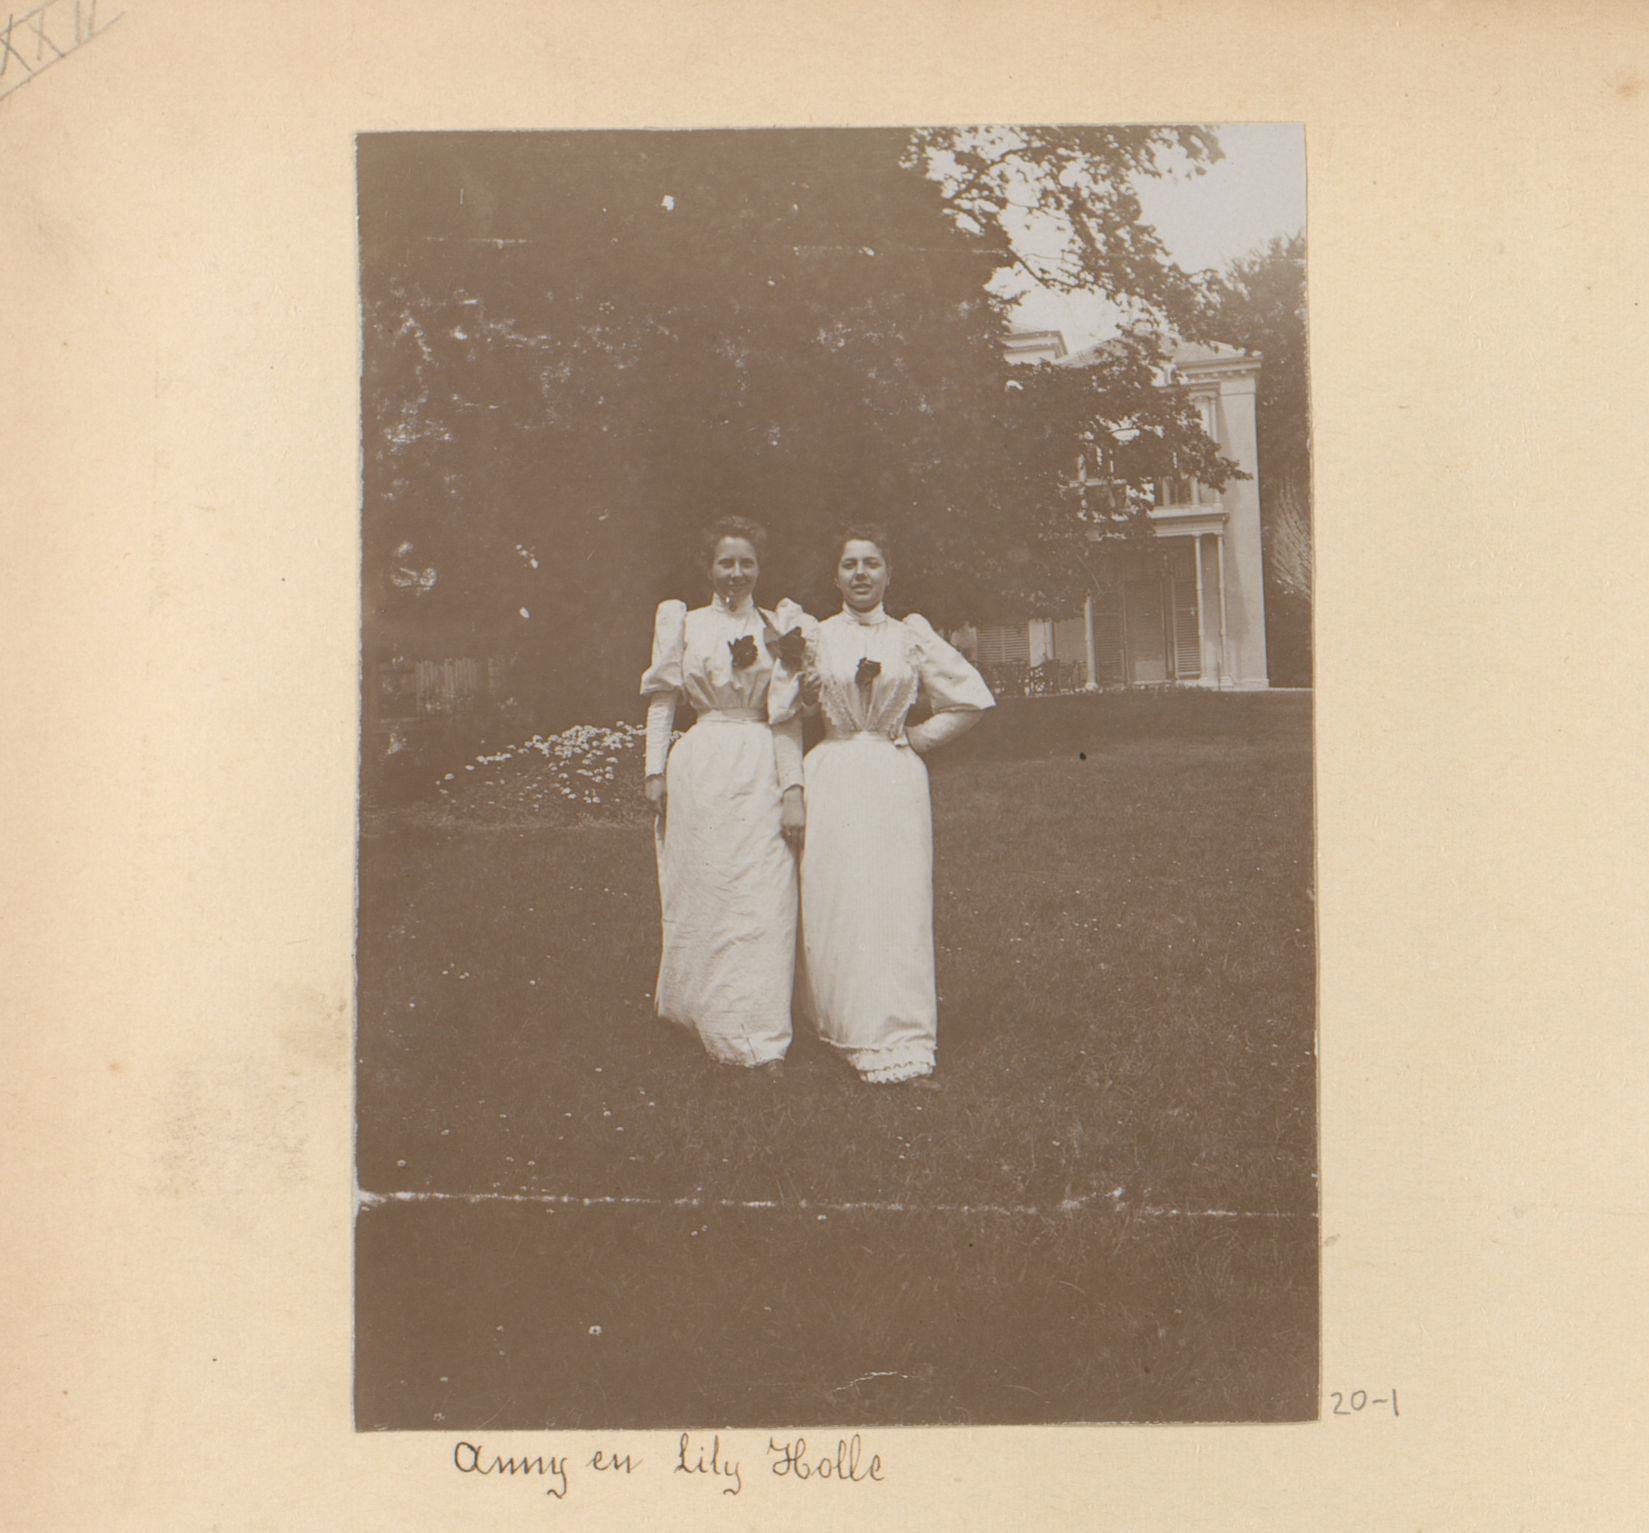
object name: album leaf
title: Portret van Annie en Lily Holle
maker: hendrik herman van den berg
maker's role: amateurfotograaf, jurist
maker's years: 1875-1944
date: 1890-1894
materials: paper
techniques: collodion silver print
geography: velsen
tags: batavia, historical persons - bb - woman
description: Foto 1 op albumblad 20 uit album "Amsterdam 1890-1894".